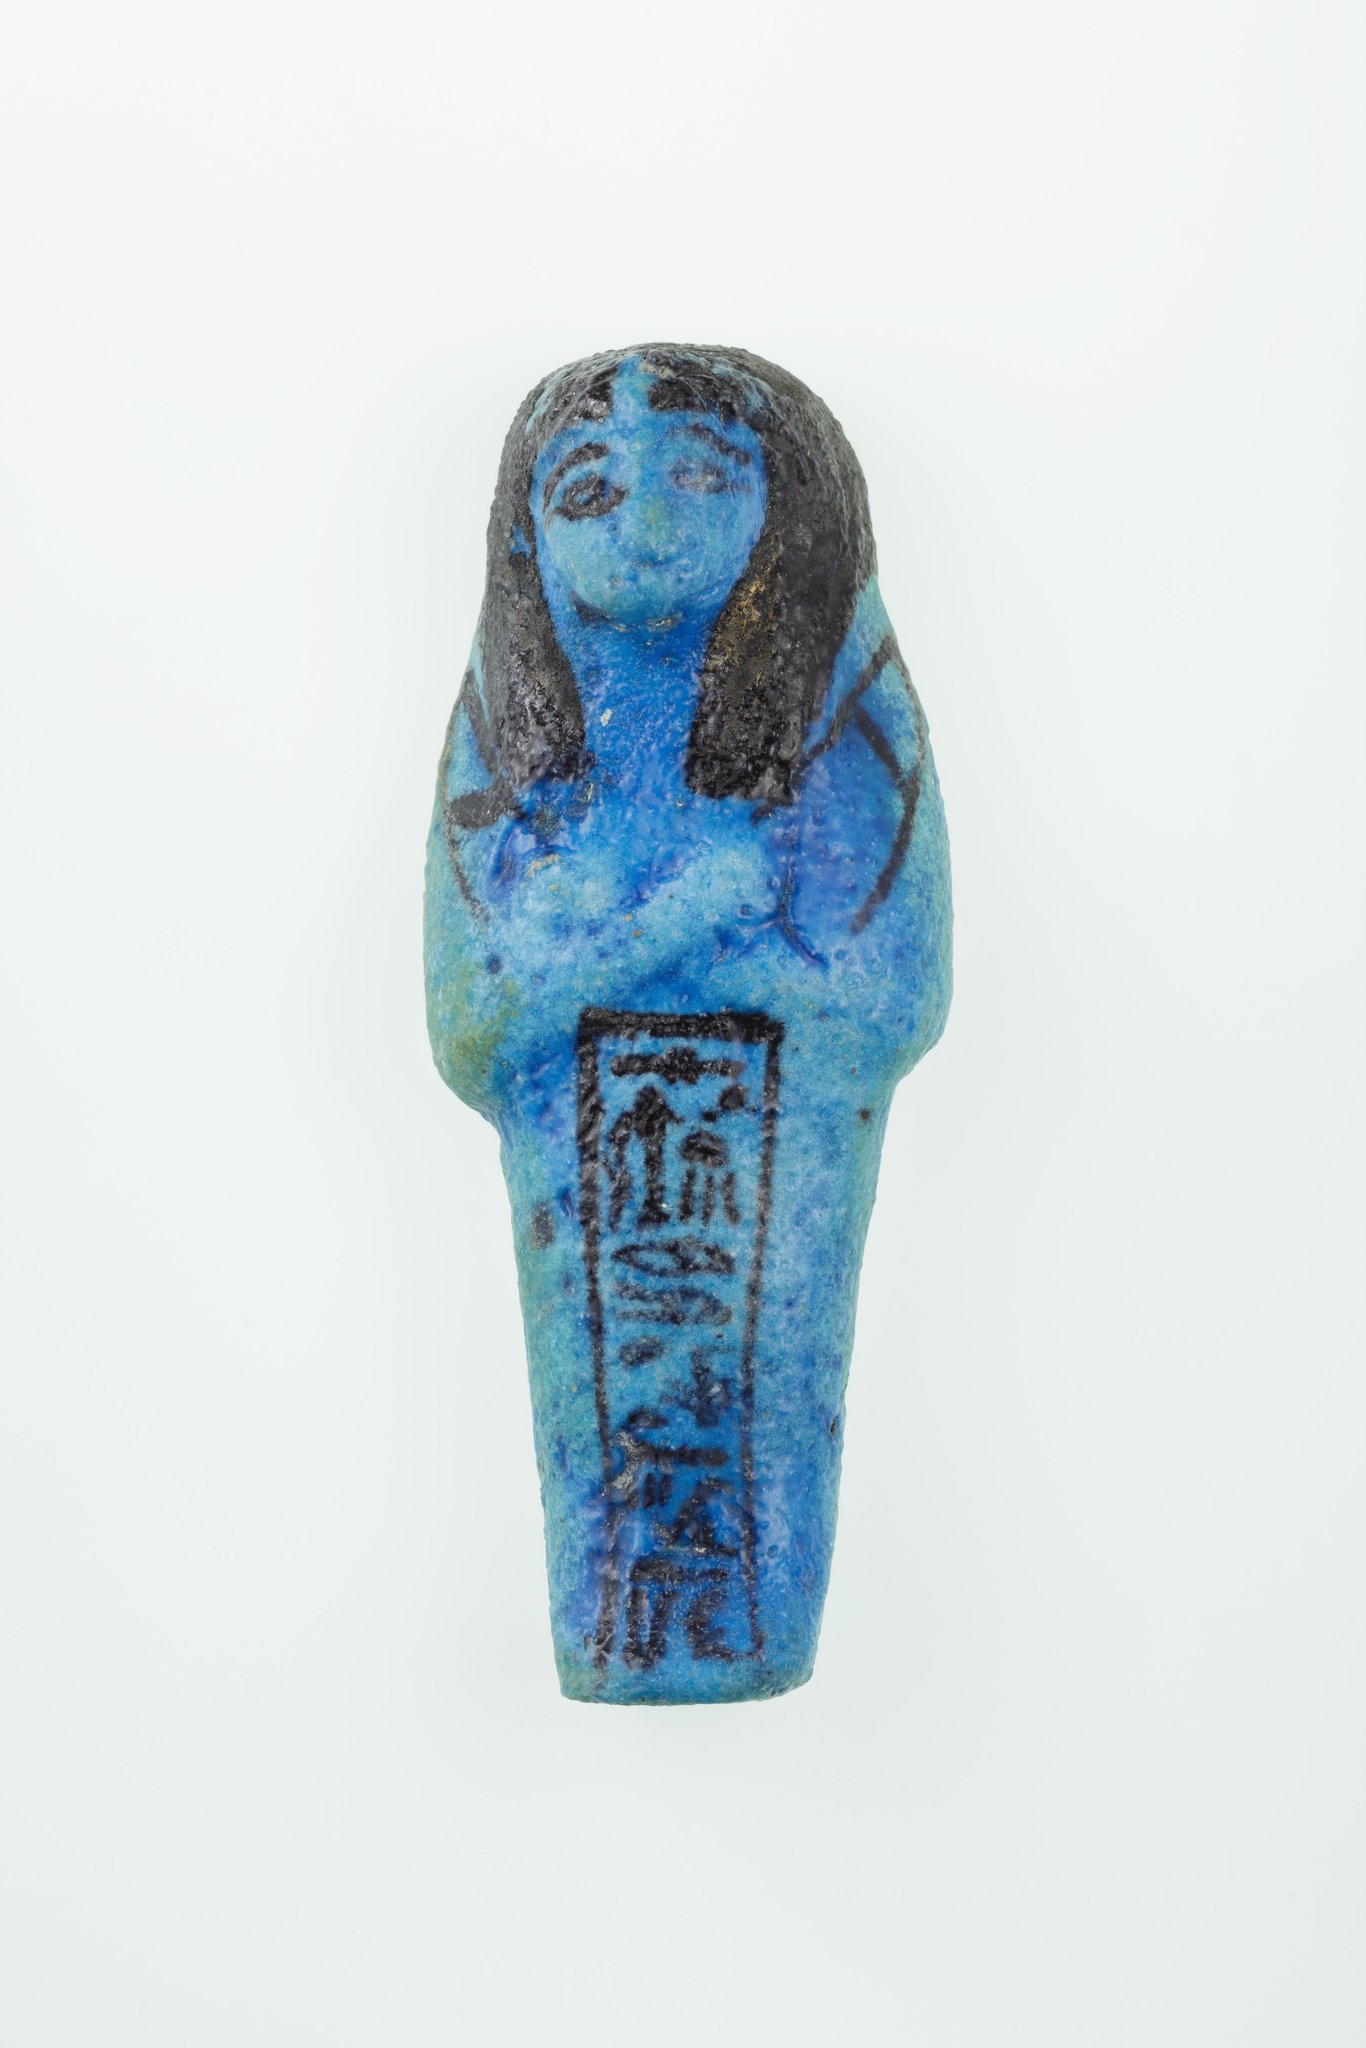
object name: shabti, worker, nauny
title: Worker Shabti of Nauny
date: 1050 BCE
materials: faience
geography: egypt